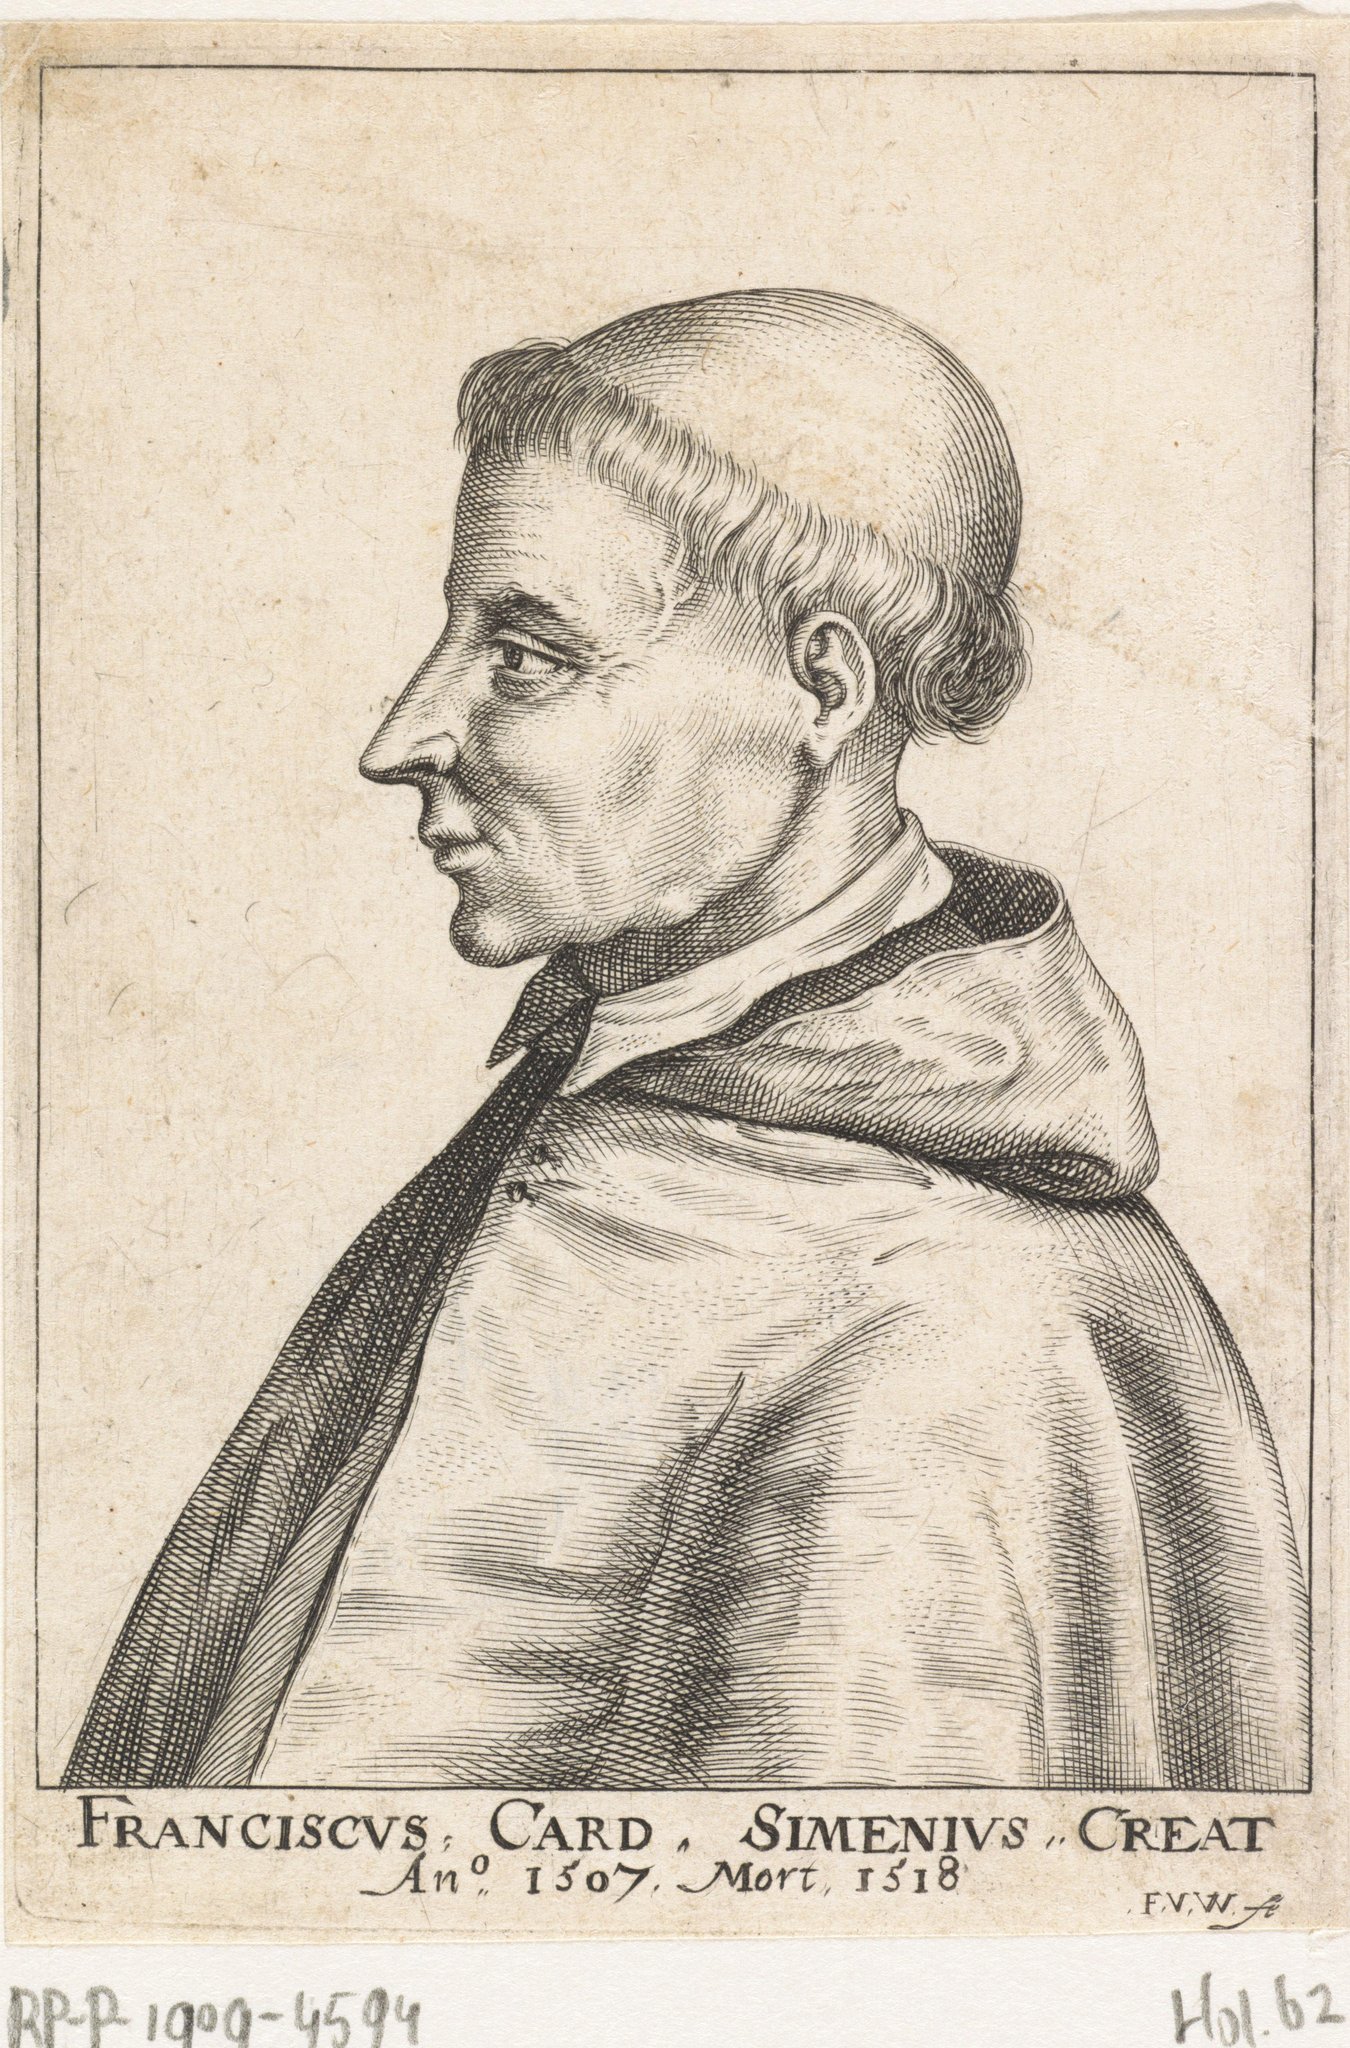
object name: print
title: Franciscvs Card. Simenivs Creat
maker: frans van den wijngaerde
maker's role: print maker, publisher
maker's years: 1614-1679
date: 1644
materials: paper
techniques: engraving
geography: antwerp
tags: spain, cardinal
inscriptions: collector's mark: Lugt 2228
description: Prent gebruikt in: Albi, Henri. Eloges historiques des Cardinaux illustres François et etrangers mis en parallele. Parijs: Anthoine de Cay, 1644.